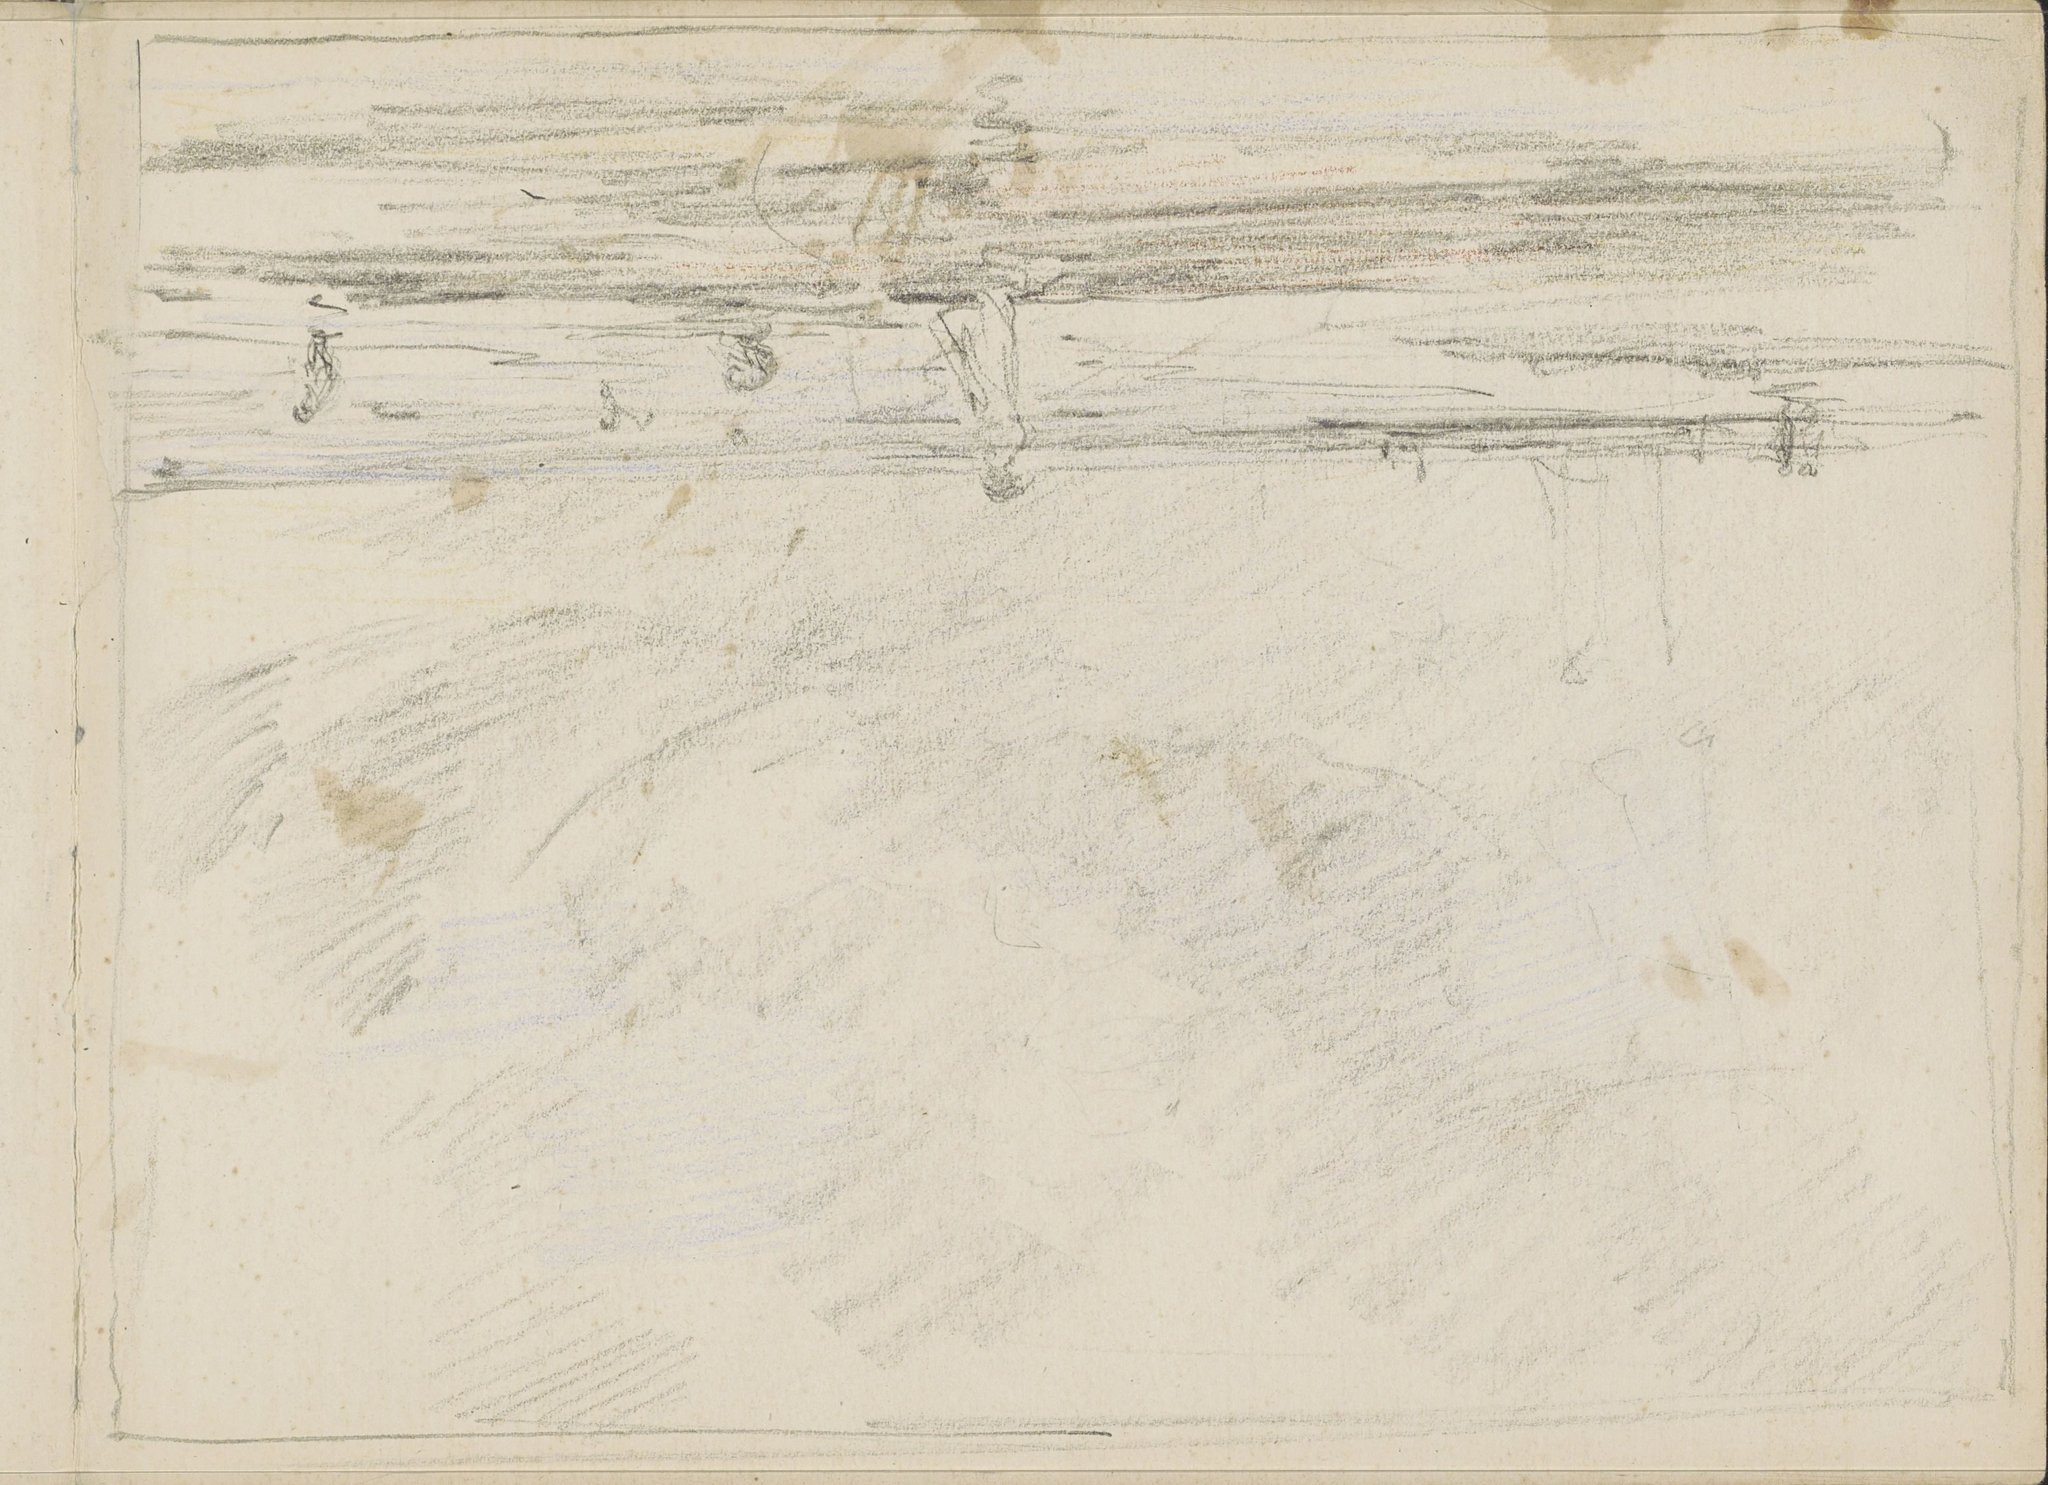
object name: sketchbook leaf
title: Gezicht op een landtong met figuren in en bij het water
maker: monogrammist ds (tekenaar)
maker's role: draughtsman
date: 1850-1950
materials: chalk, paper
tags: beach (+ landscape with figures, staffage)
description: Tekening in een kader. Blad 12 recto uit een schetsboek met 17 bladen.